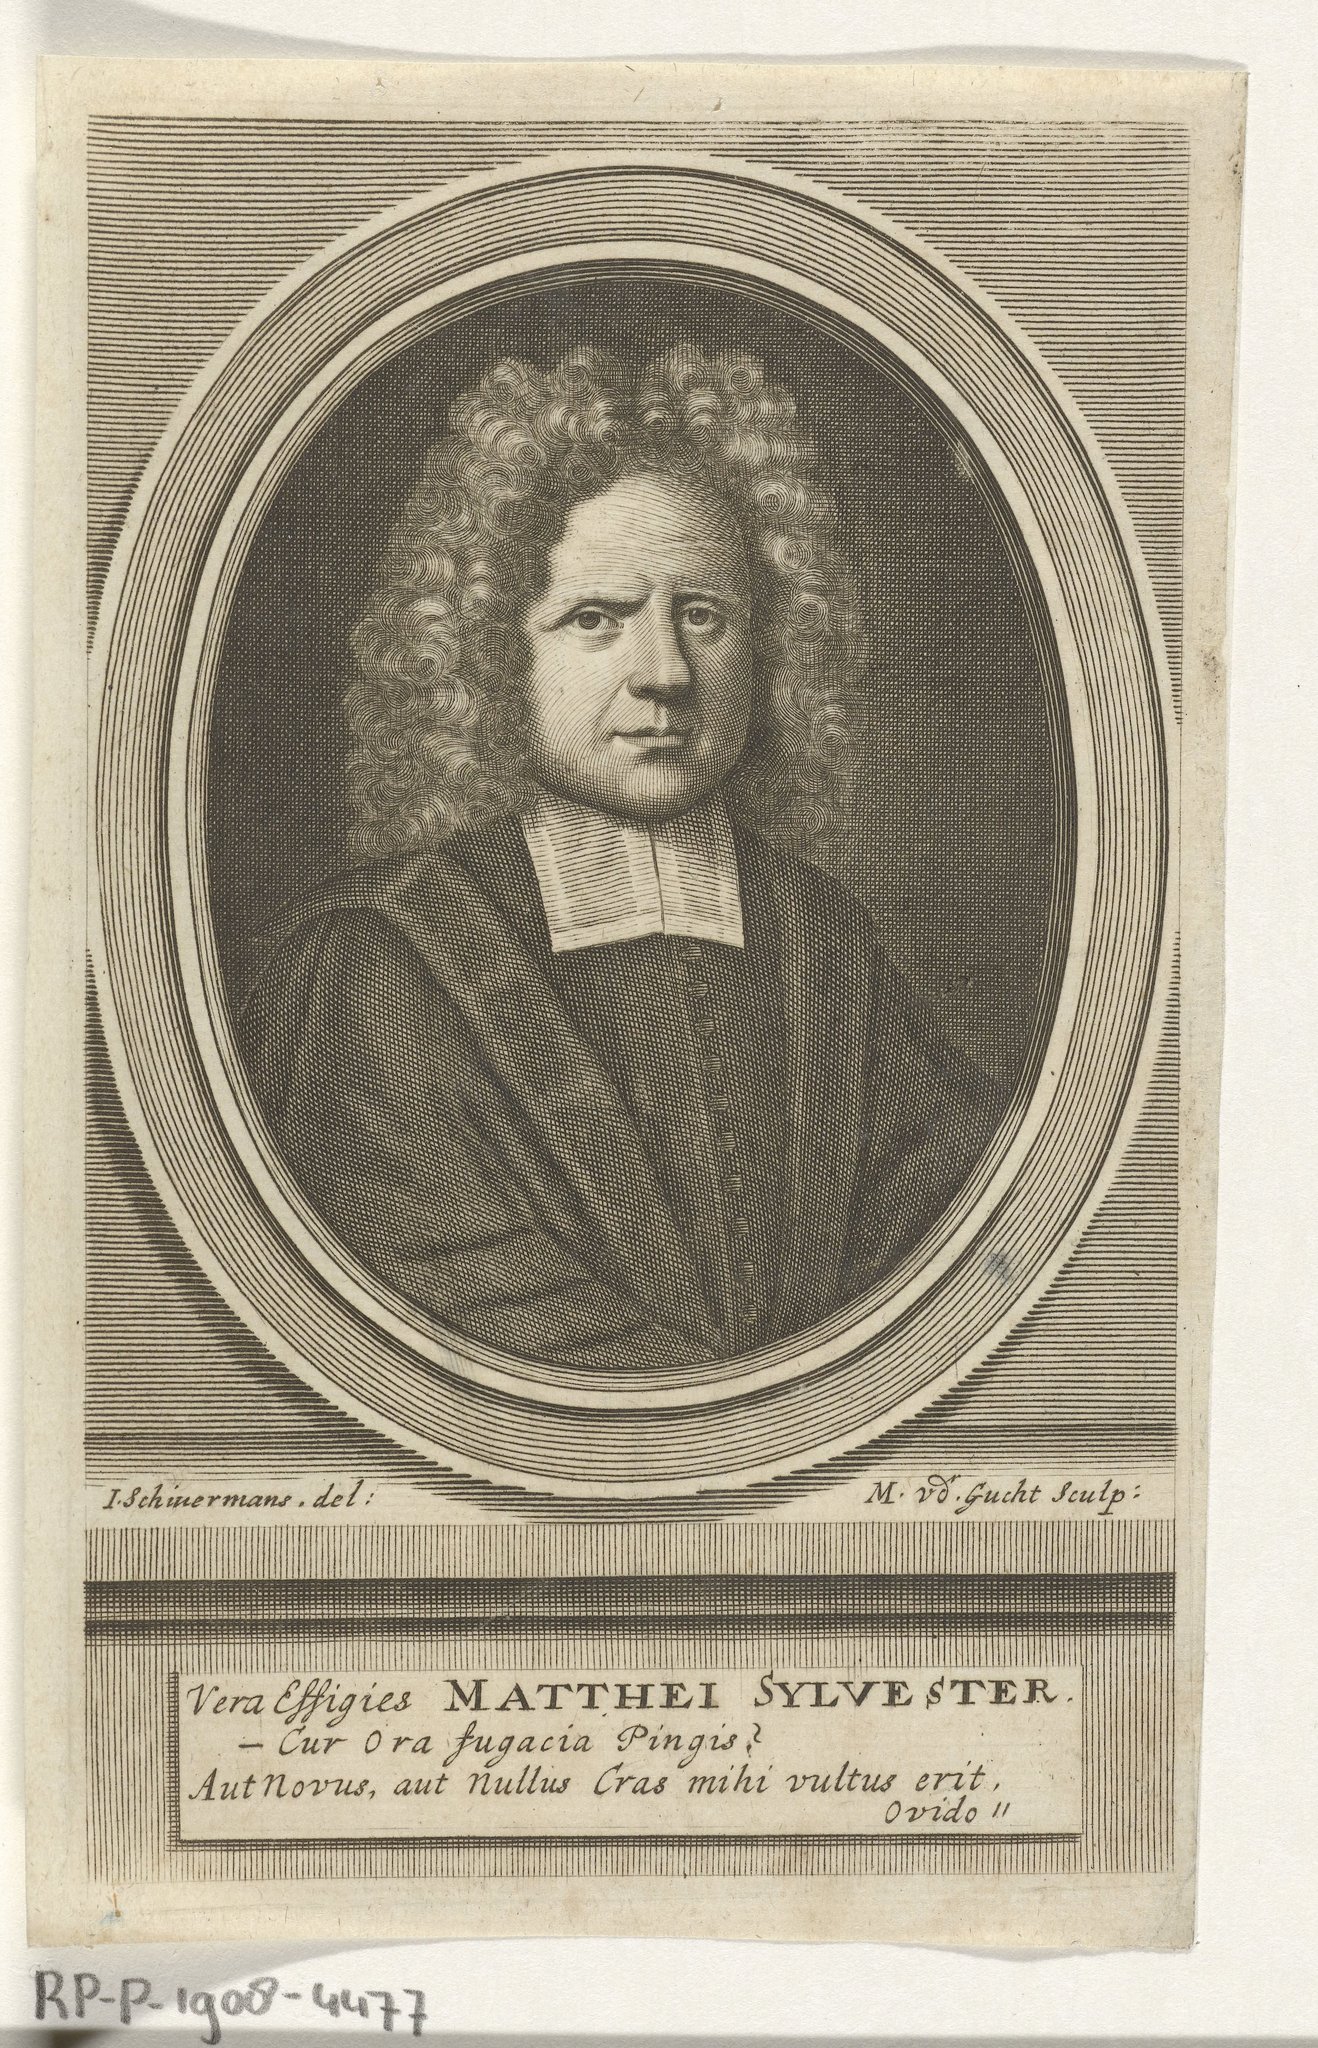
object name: print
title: Portret van Matthew Sylvester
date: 1670-1725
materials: paper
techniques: engraving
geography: antwerp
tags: southwell, matthew sylvester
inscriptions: collector's mark: Lugt 2228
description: Busteportret van Matthew Sylvester, in toga. Het portret is gevat in een ovale omlijsting. Onder de voorstelling de naam van de geportretteerde en twee tekstregels van Ovidius.